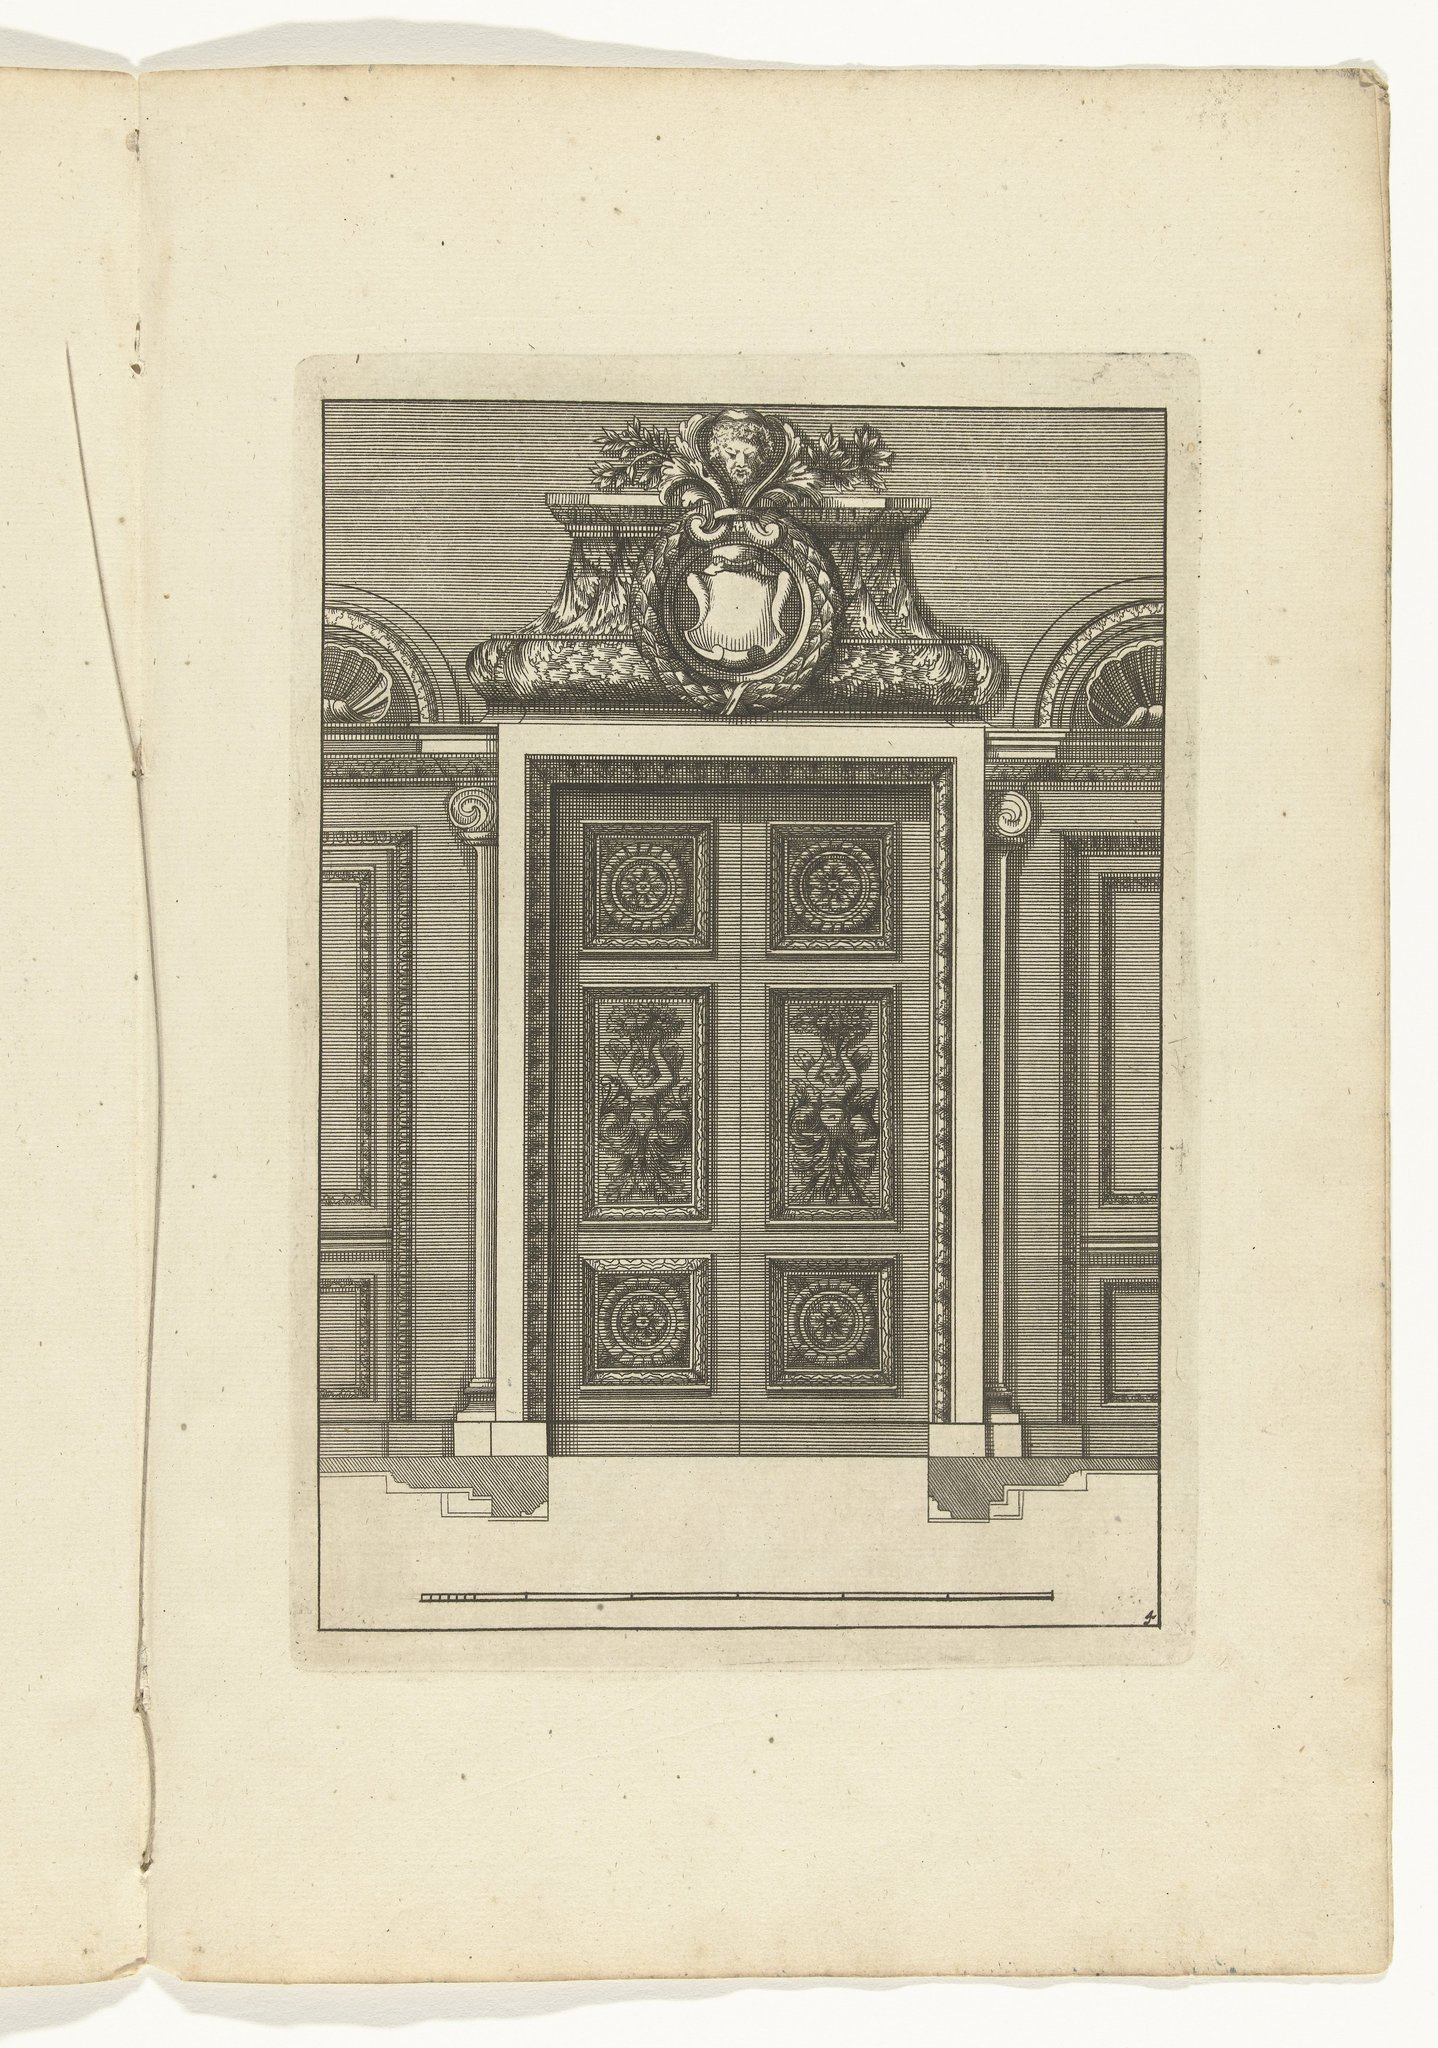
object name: print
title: Nouveau Livre d' Porte d'La Chambre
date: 1726-1750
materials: paper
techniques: etching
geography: netherlands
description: De middelste panelen zijn groter, met putti die ontspruiten uit bladranken en een vaas met fruit boven hun hoofd houden. Met opstand en plan onderaan. Tweede editie.